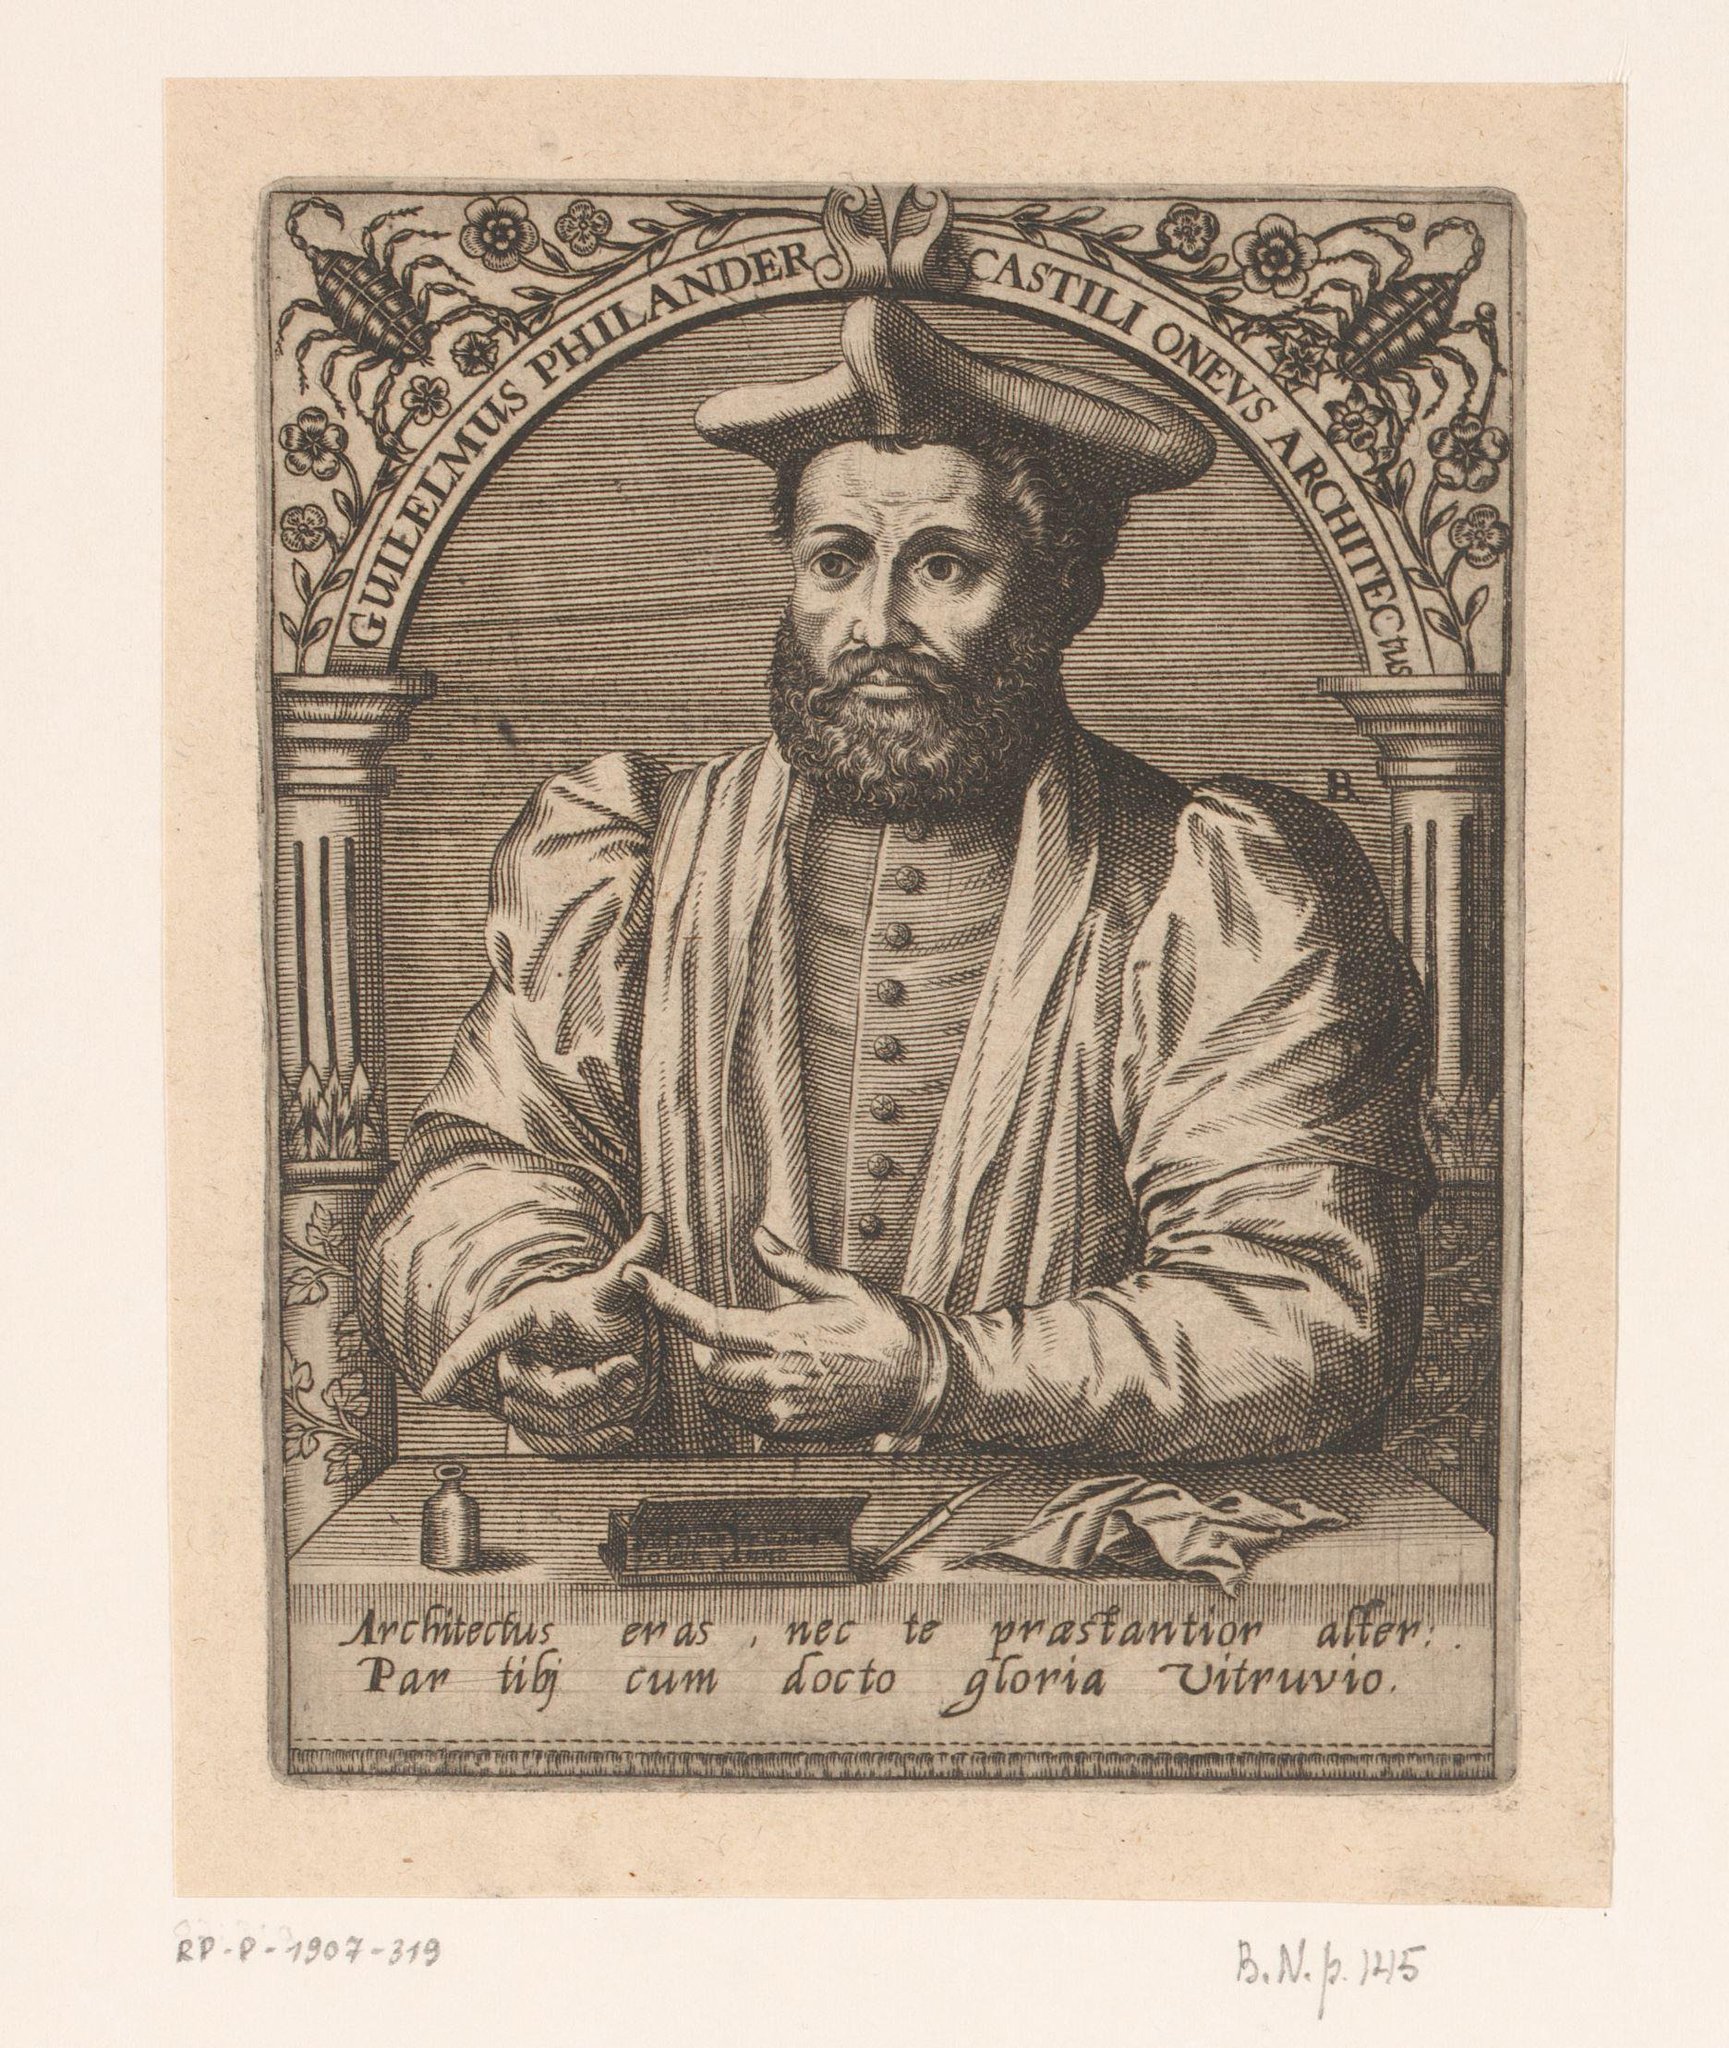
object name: print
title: Guilelmus Philander Castili oneus architectus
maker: robert boissard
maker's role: print maker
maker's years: 1570-1611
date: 1597-1599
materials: paper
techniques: engraving, intaglio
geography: france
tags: priest, ink-well, scorpions - ff - fabulous animals (sometimes wrongly called 'grotesques'); 'mostri' (ripa), historical persons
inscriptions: collector's mark: Lugt 2228